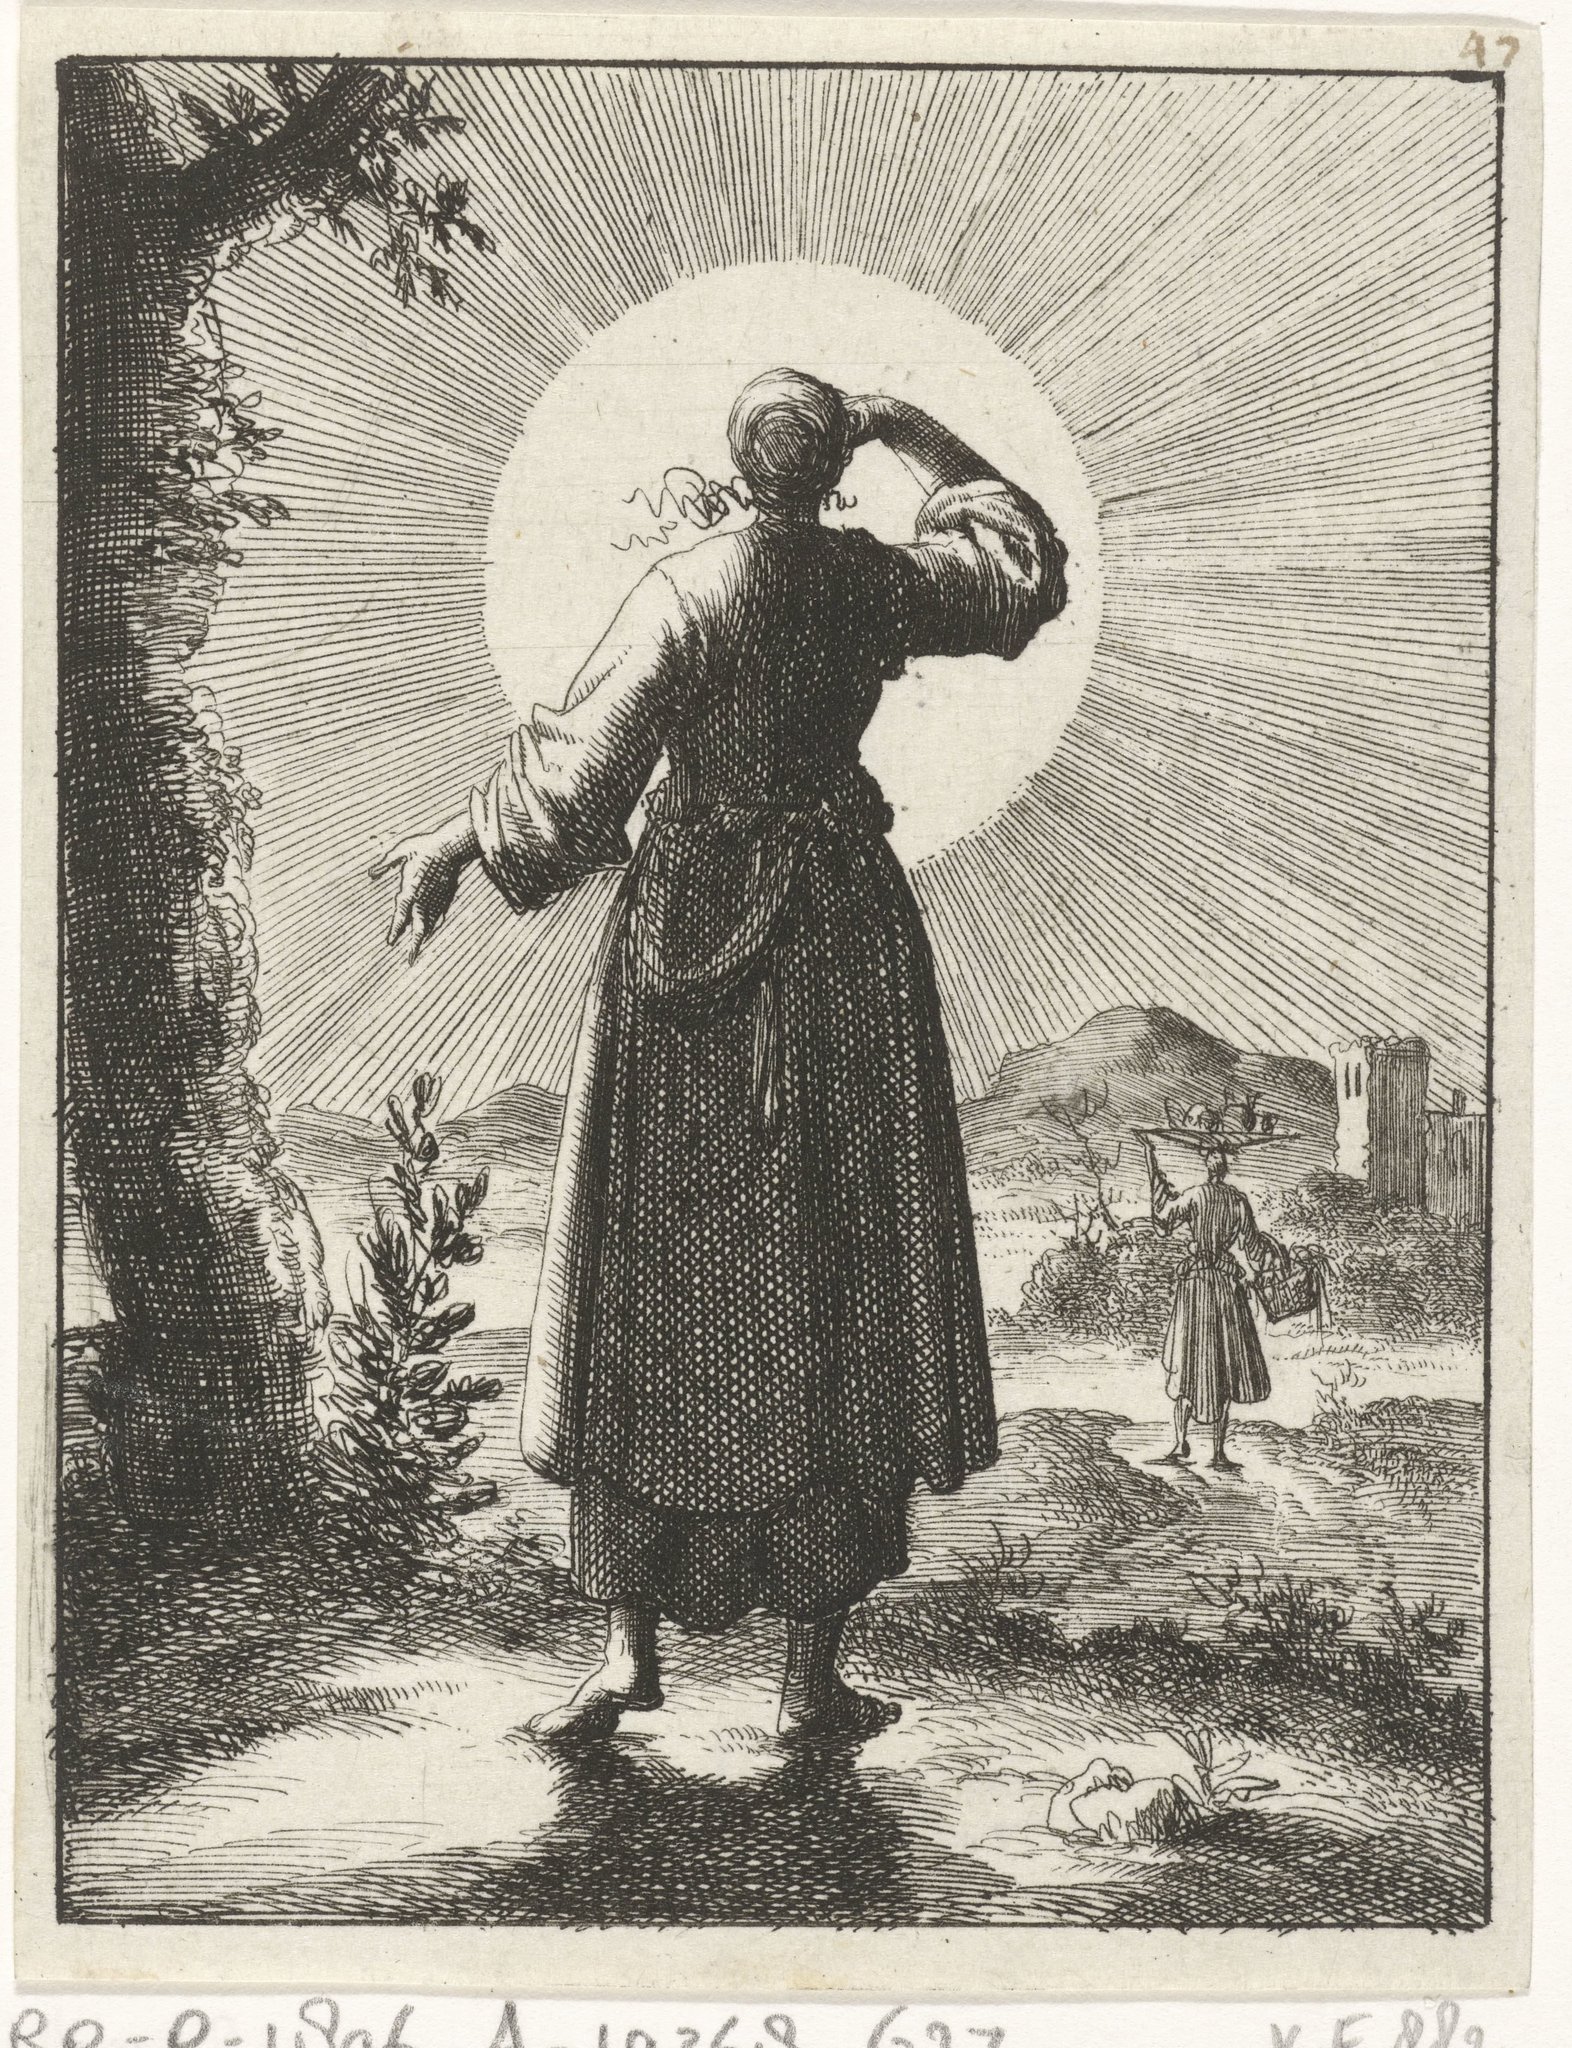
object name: book illustration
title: Vrouw houdt bij het kijken naar de zon haar hand voor de ogen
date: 1687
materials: paper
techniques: etching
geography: amsterdam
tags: physical aspects of the sun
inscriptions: collector's mark: Lugt 2228, number: ‘47’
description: Illustratie uit: Luyken, Jan. Voncken der liefde Jesu, van het godtbegerende zielenvier. Amsterdam: Pieter Arentsz (II), 1687, p. 198.